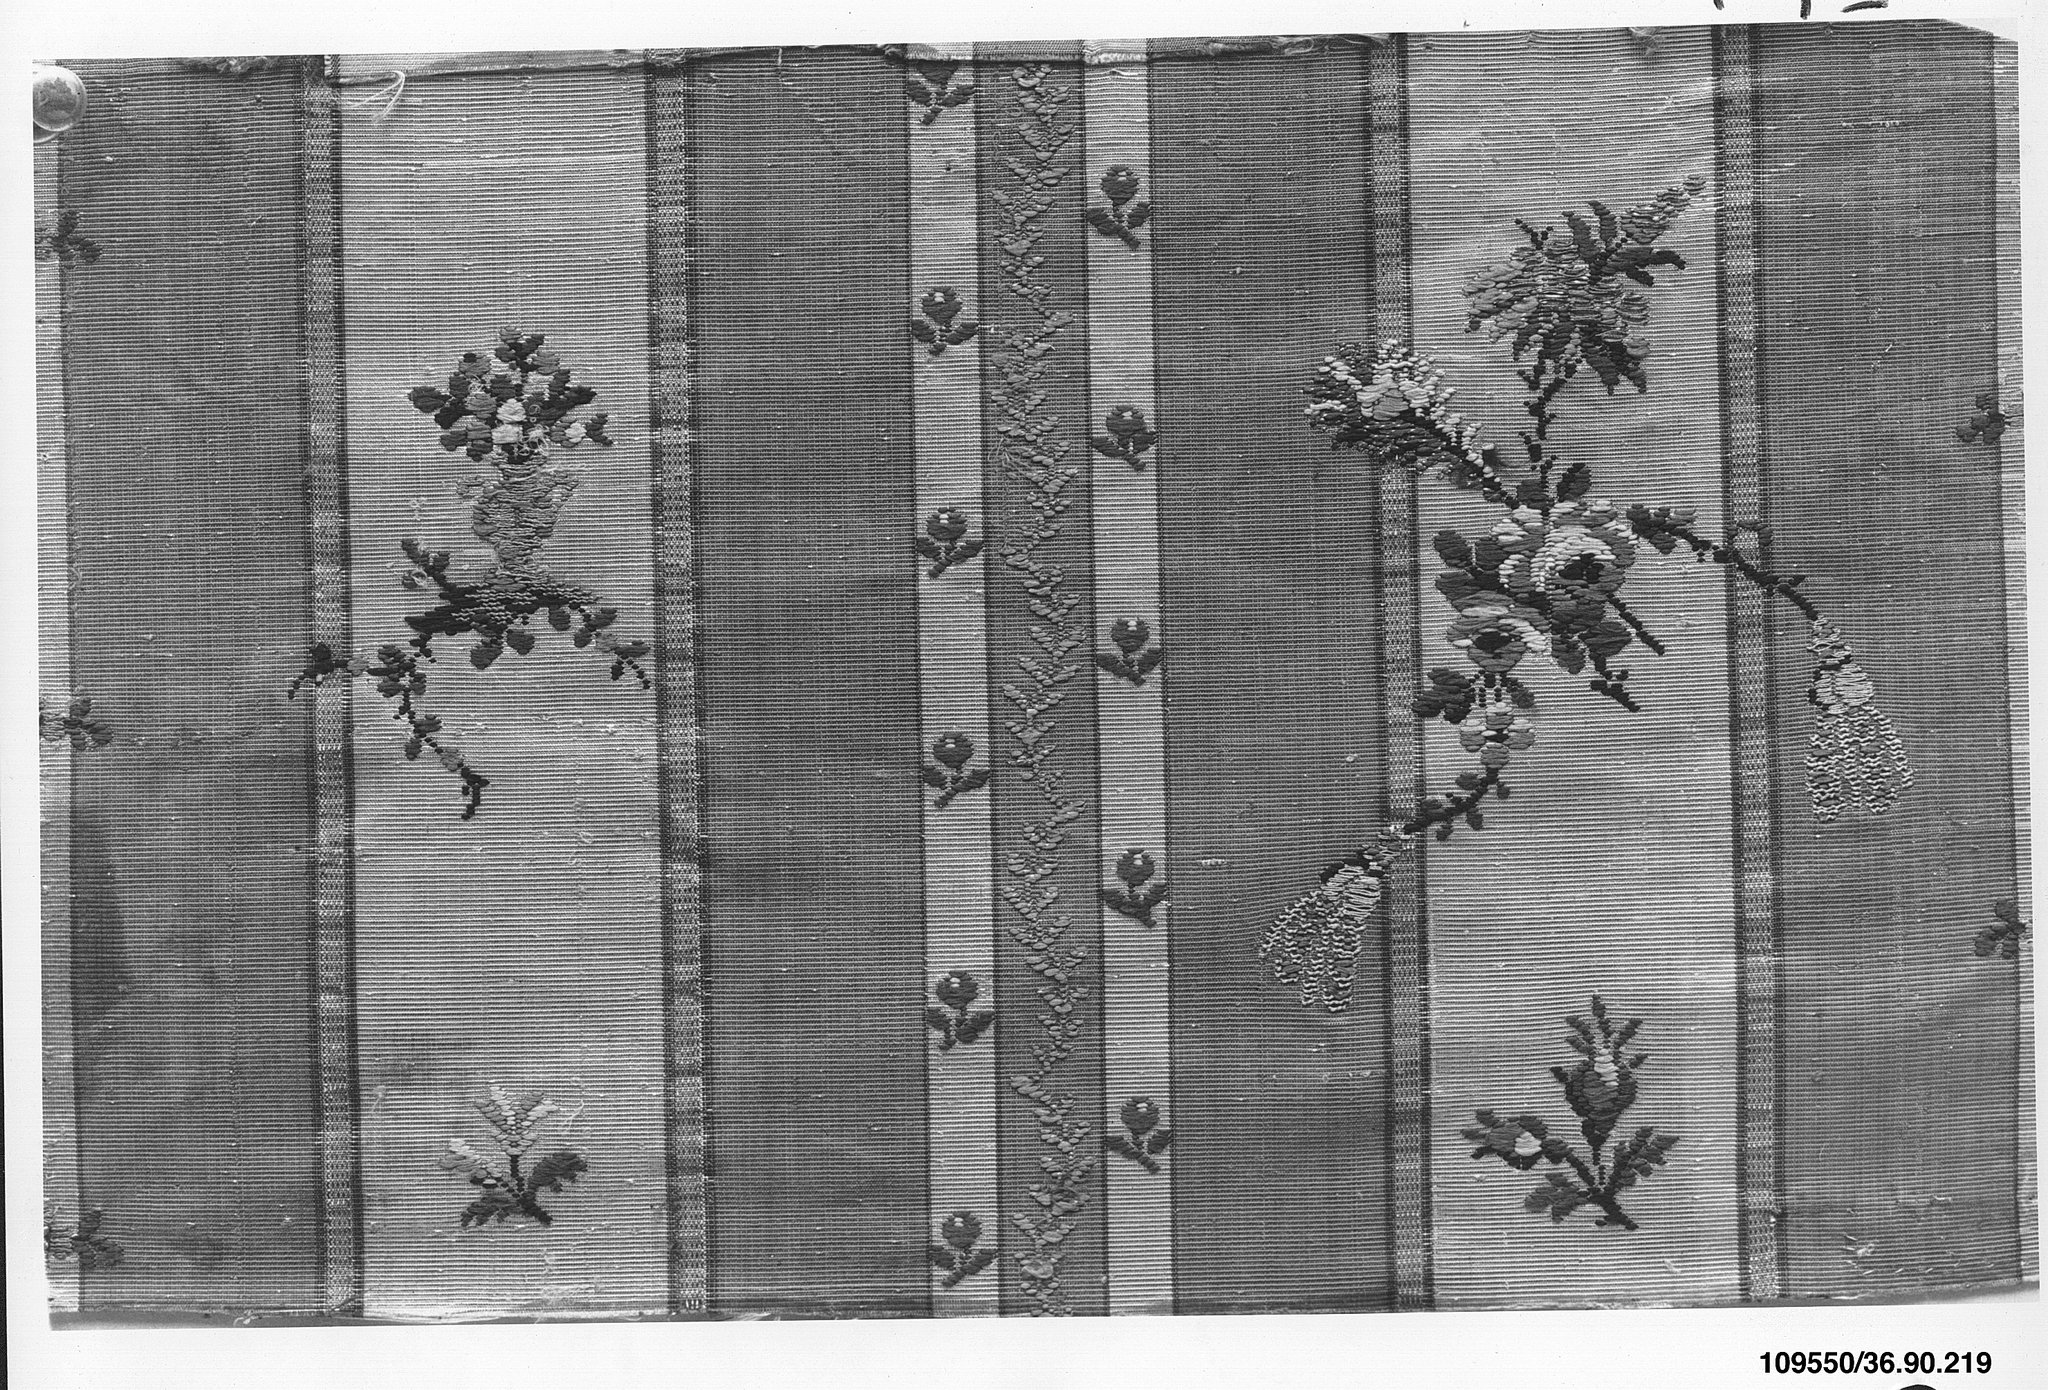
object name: piece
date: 1701-1800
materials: metal thread, silk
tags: flowers,leaves